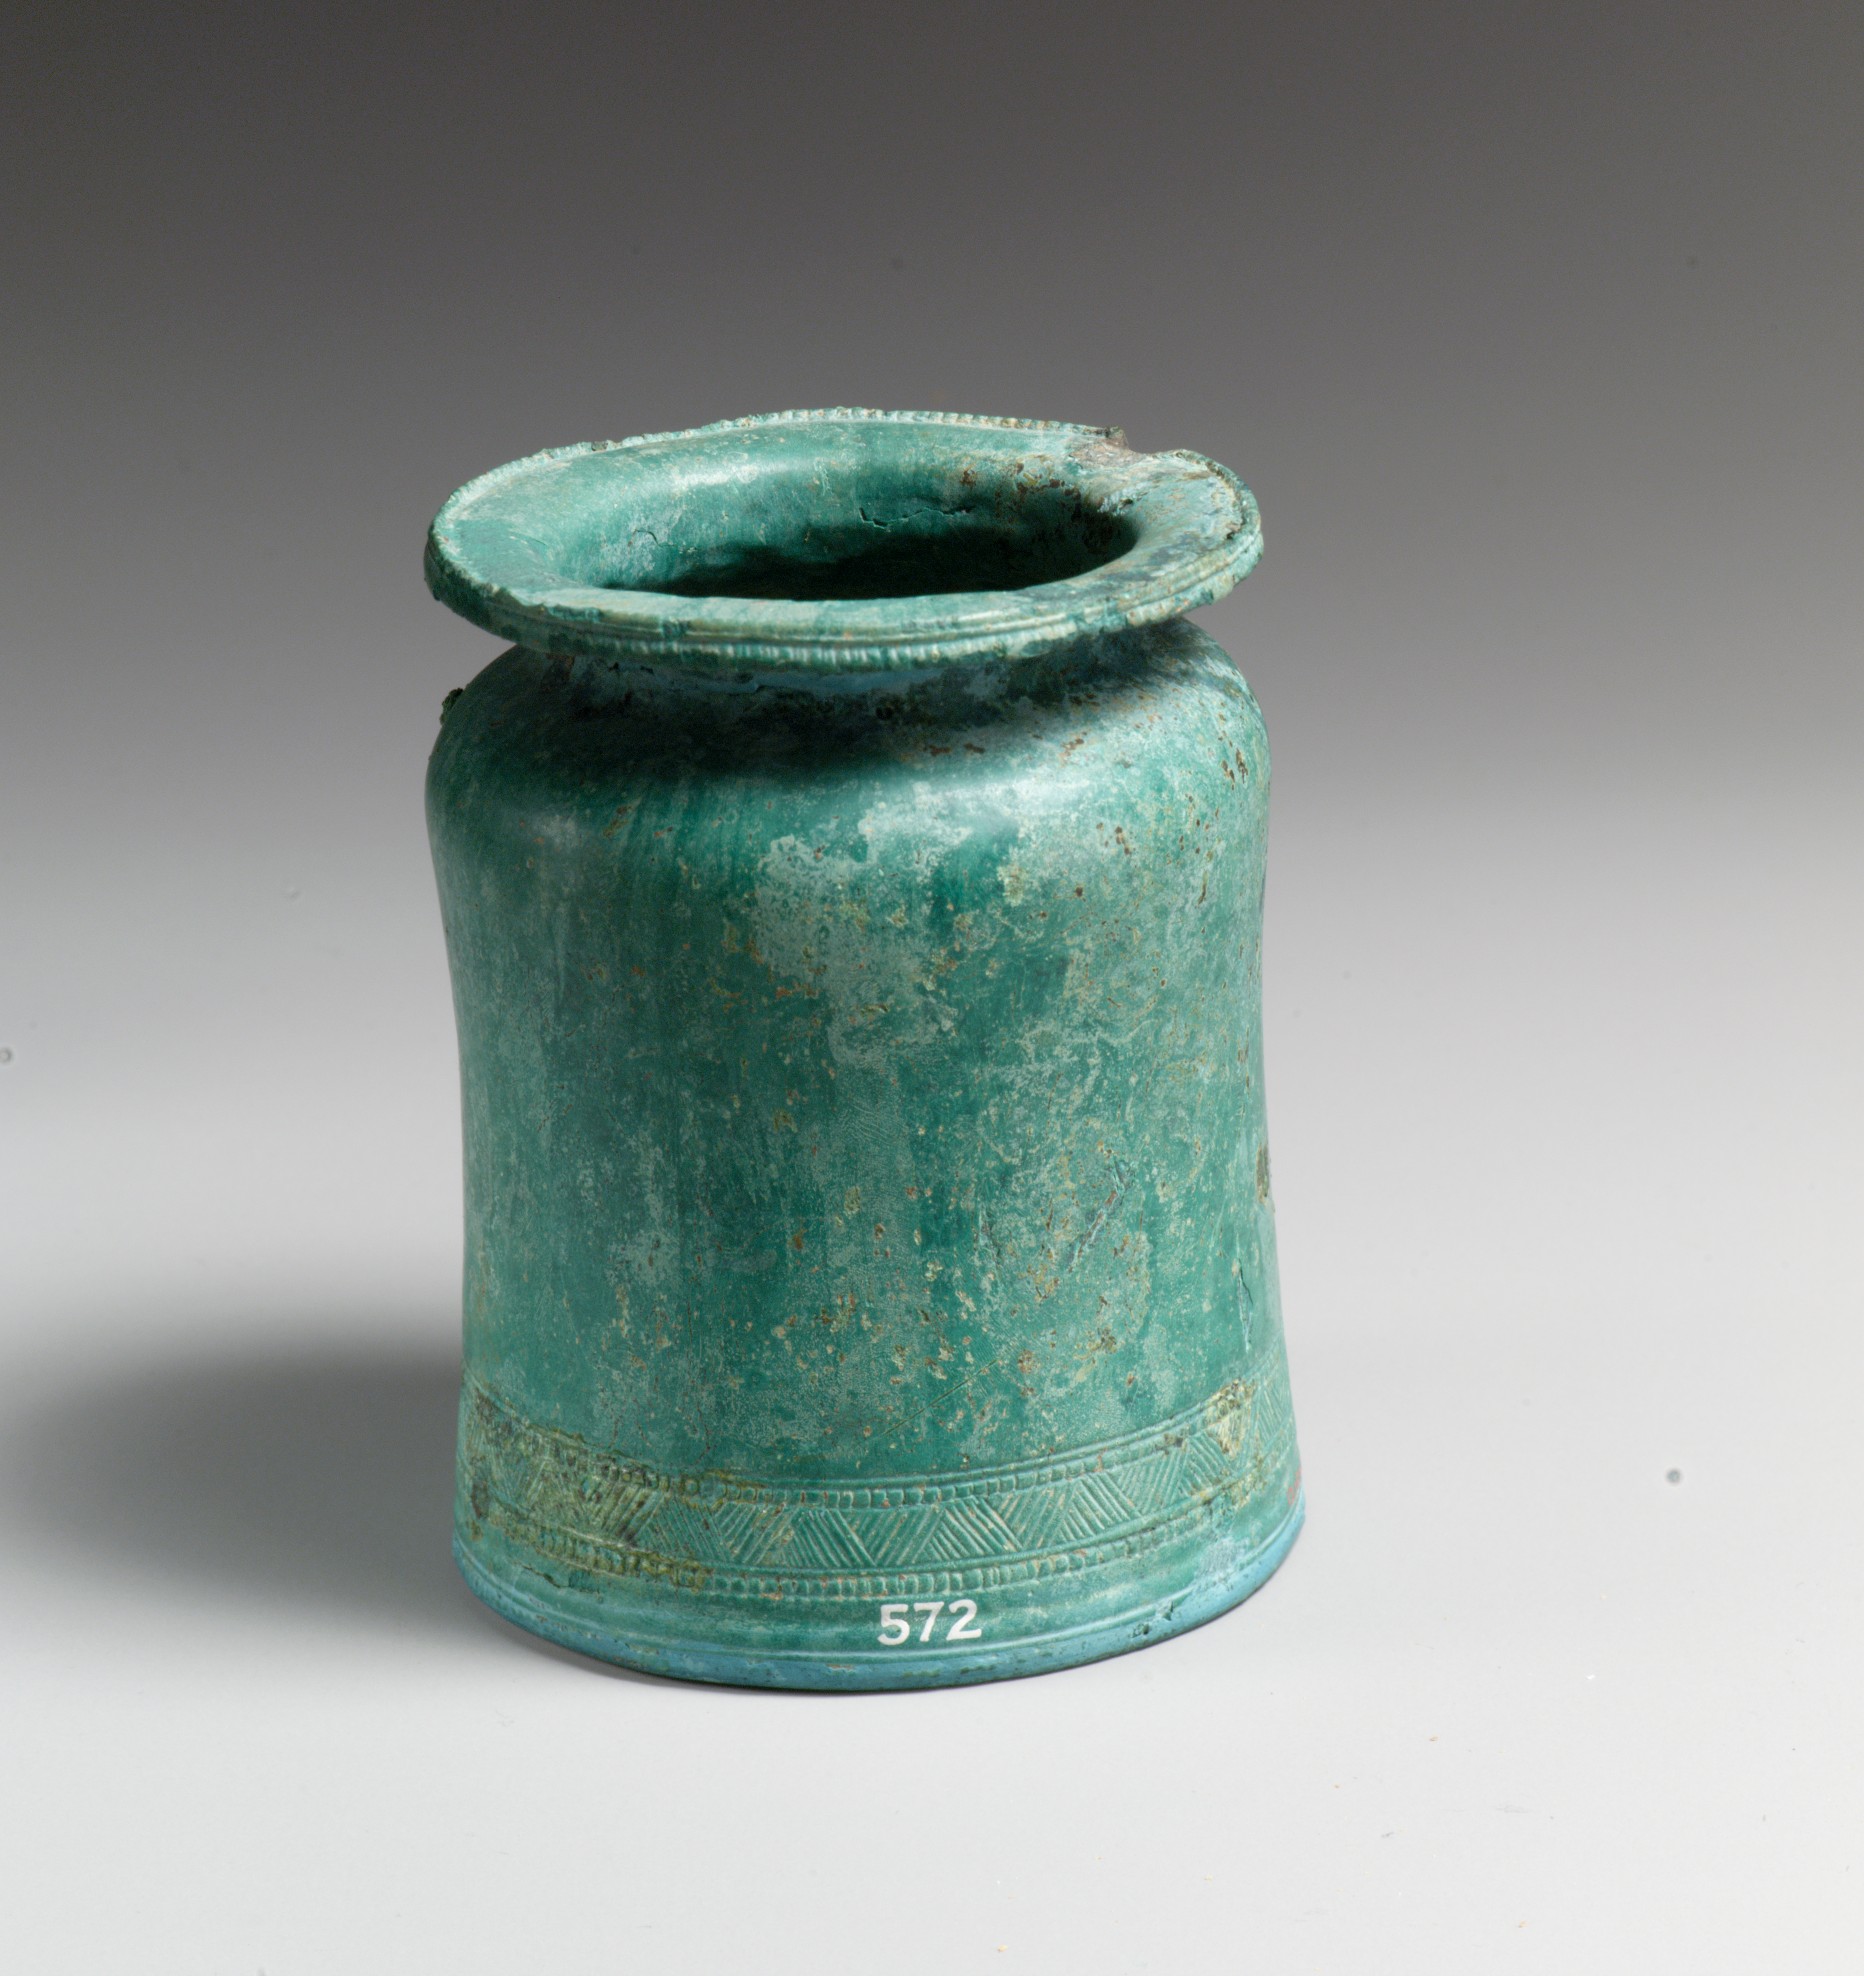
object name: cup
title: Bronze kyathos (ladle)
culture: etruscan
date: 450-400 BCE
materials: bronze